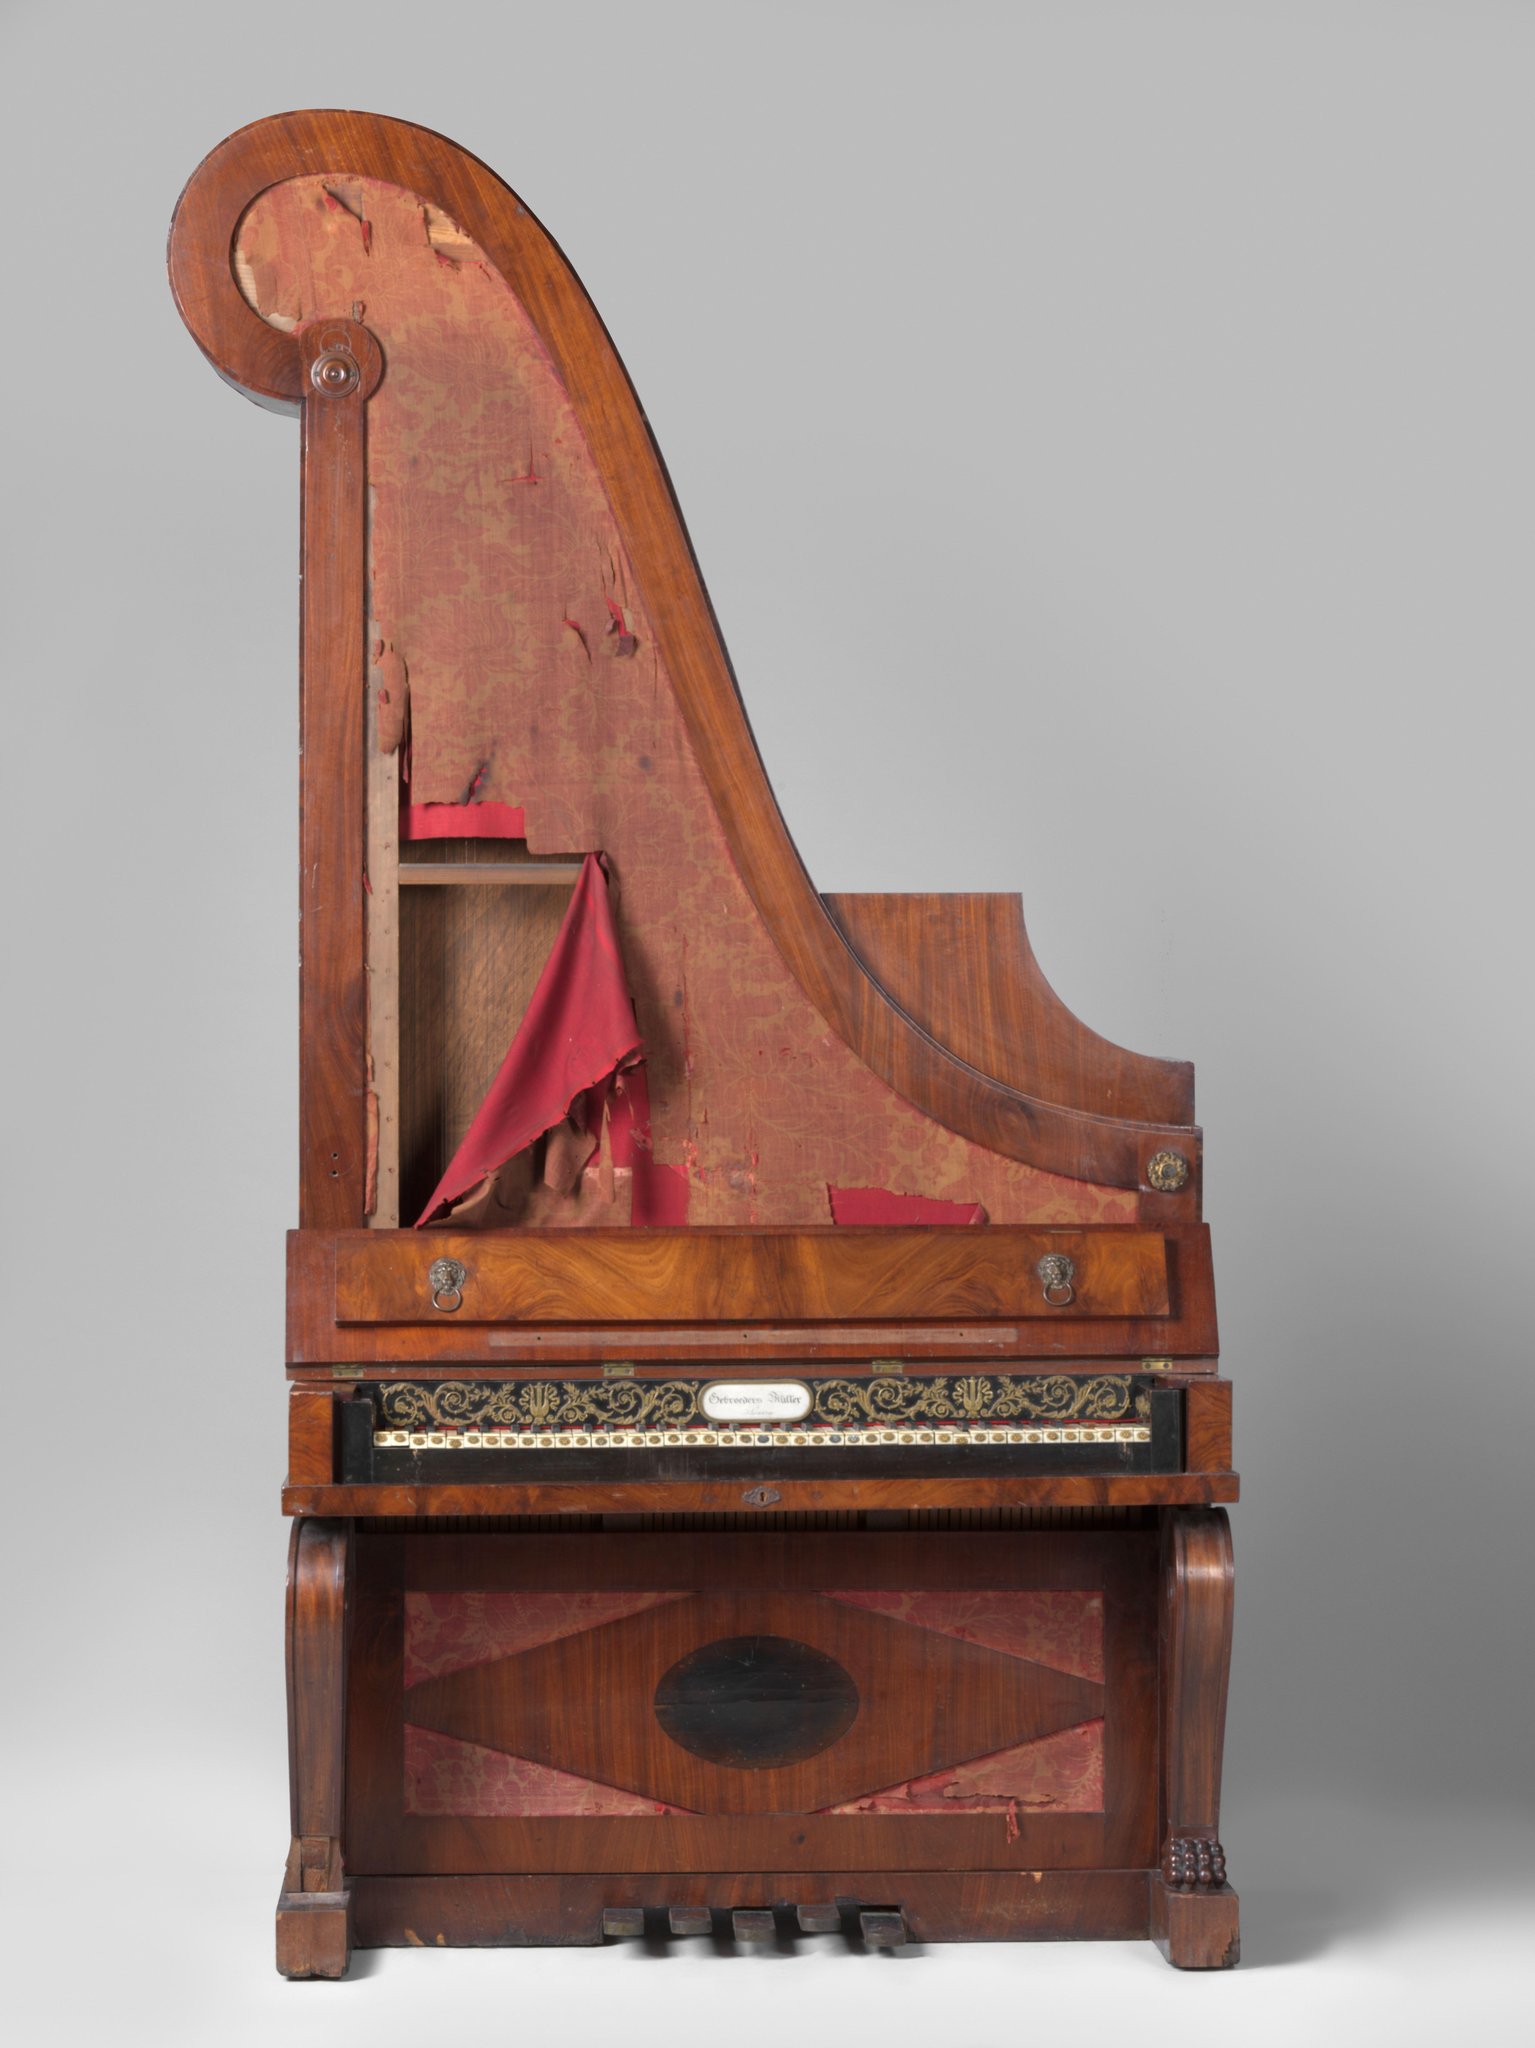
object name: pianoforte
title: Giraffe piano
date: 1820-1830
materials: wood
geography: amsterdam